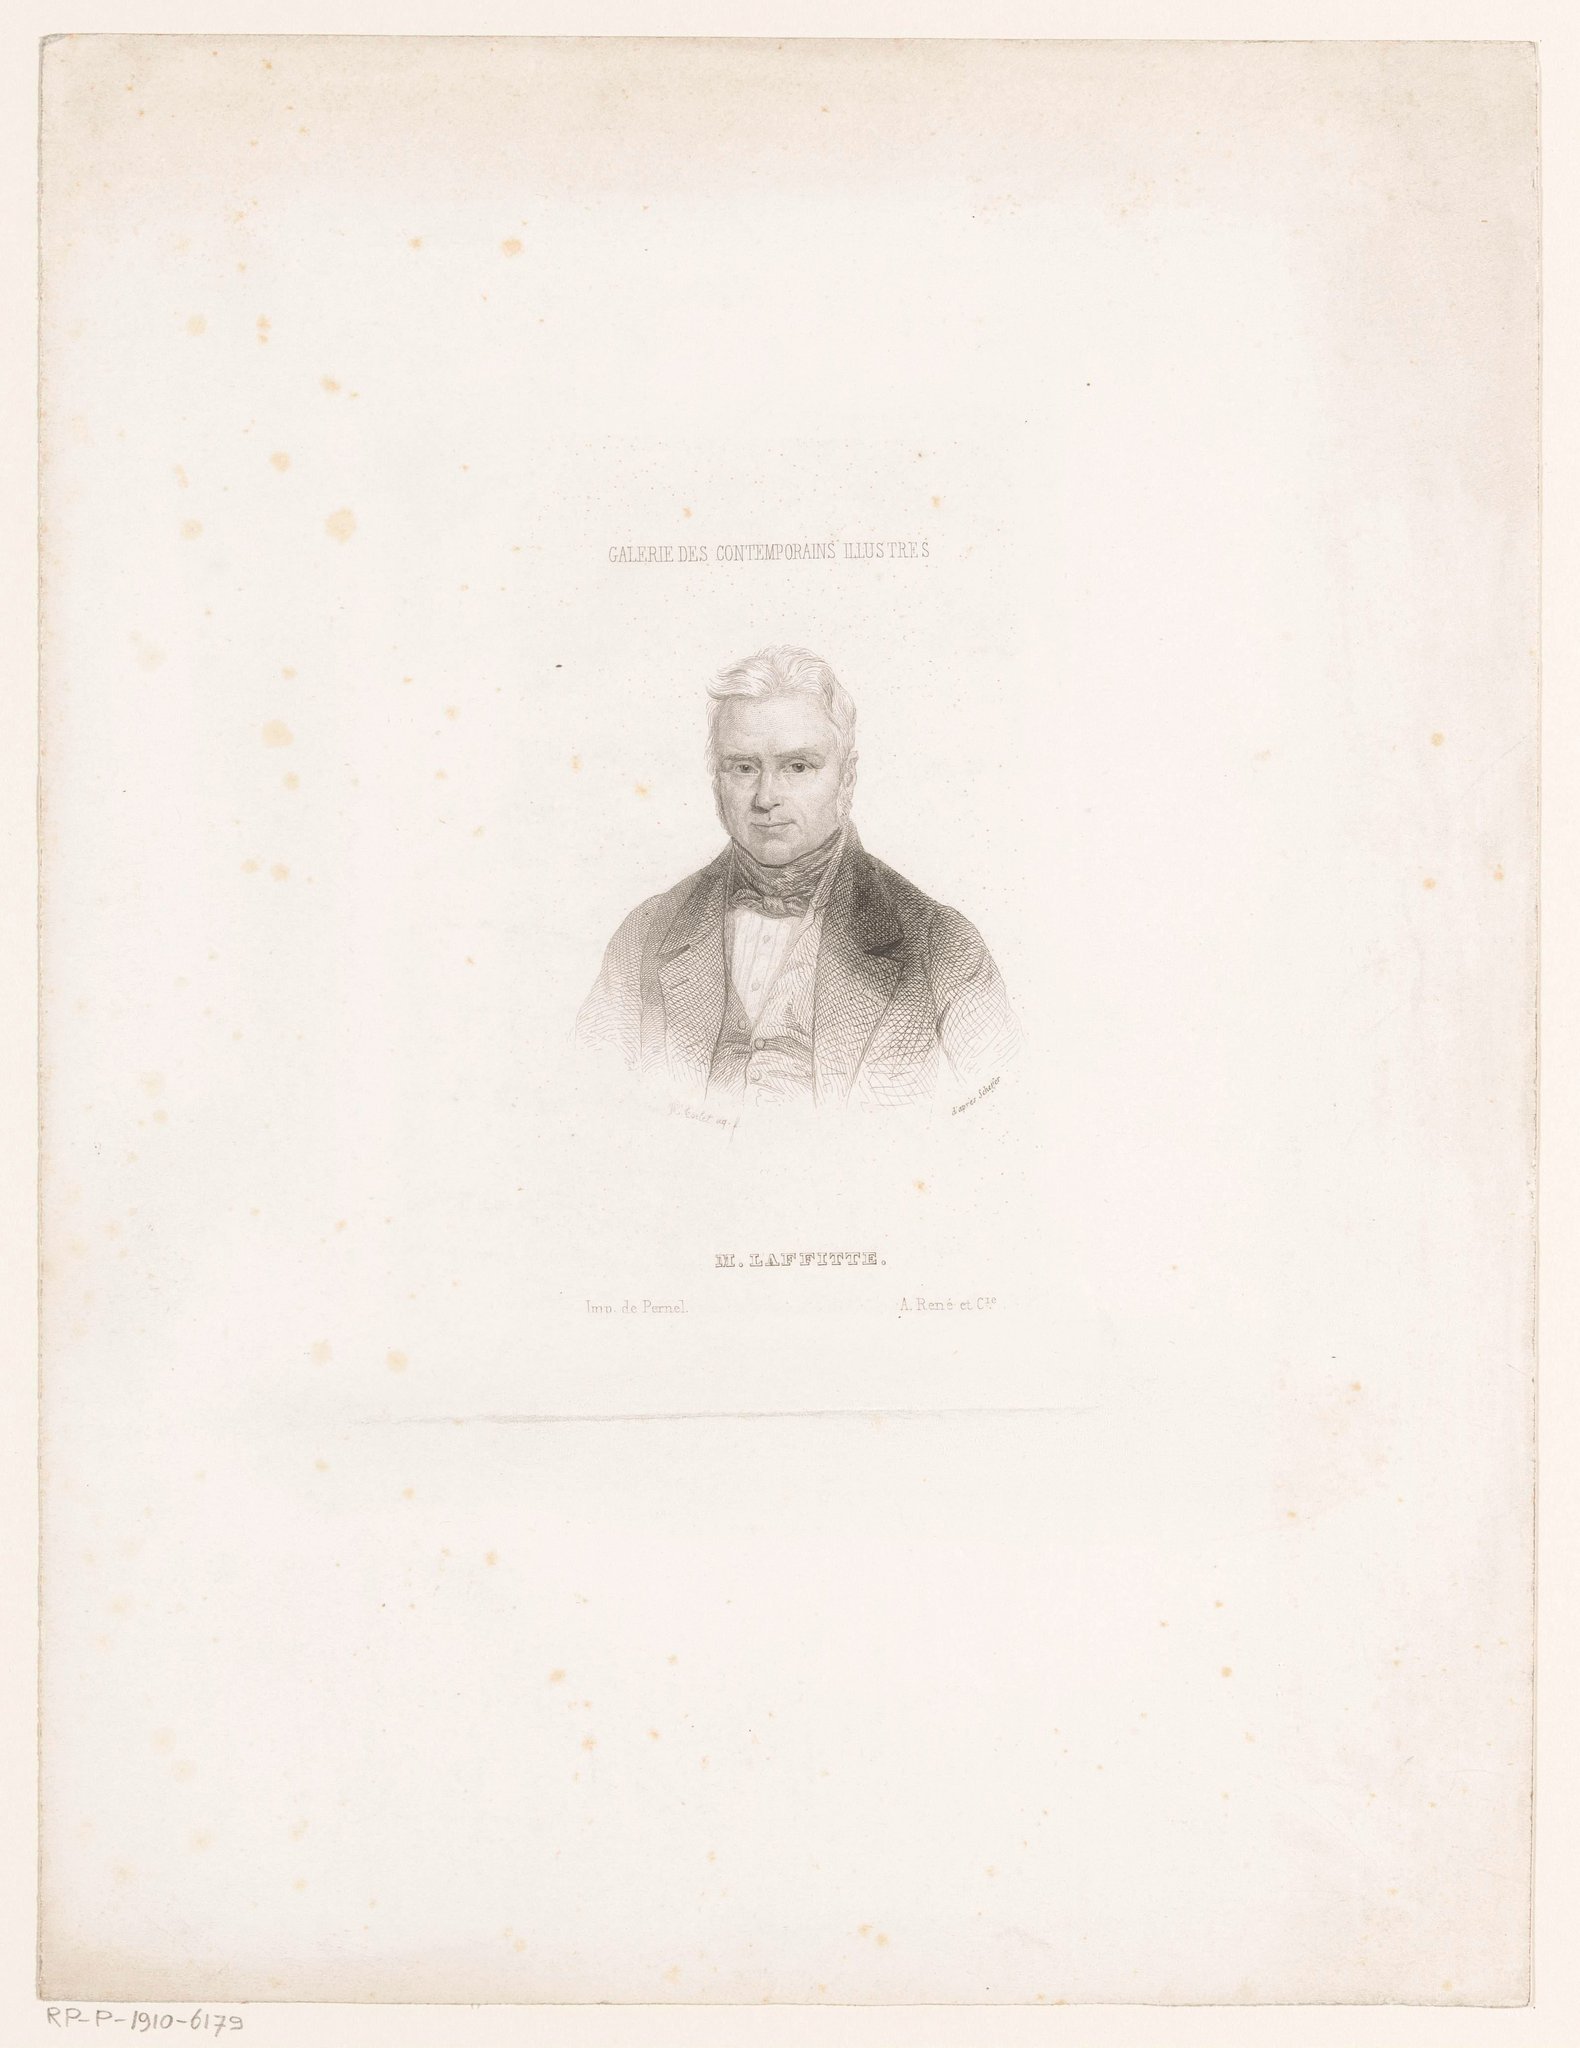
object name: print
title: Portret van Jacques Laffitte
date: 1845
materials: paper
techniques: etching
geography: france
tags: politician, banker, historical persons, politician, e.g. party leader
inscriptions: collector's mark: Lugt 2228